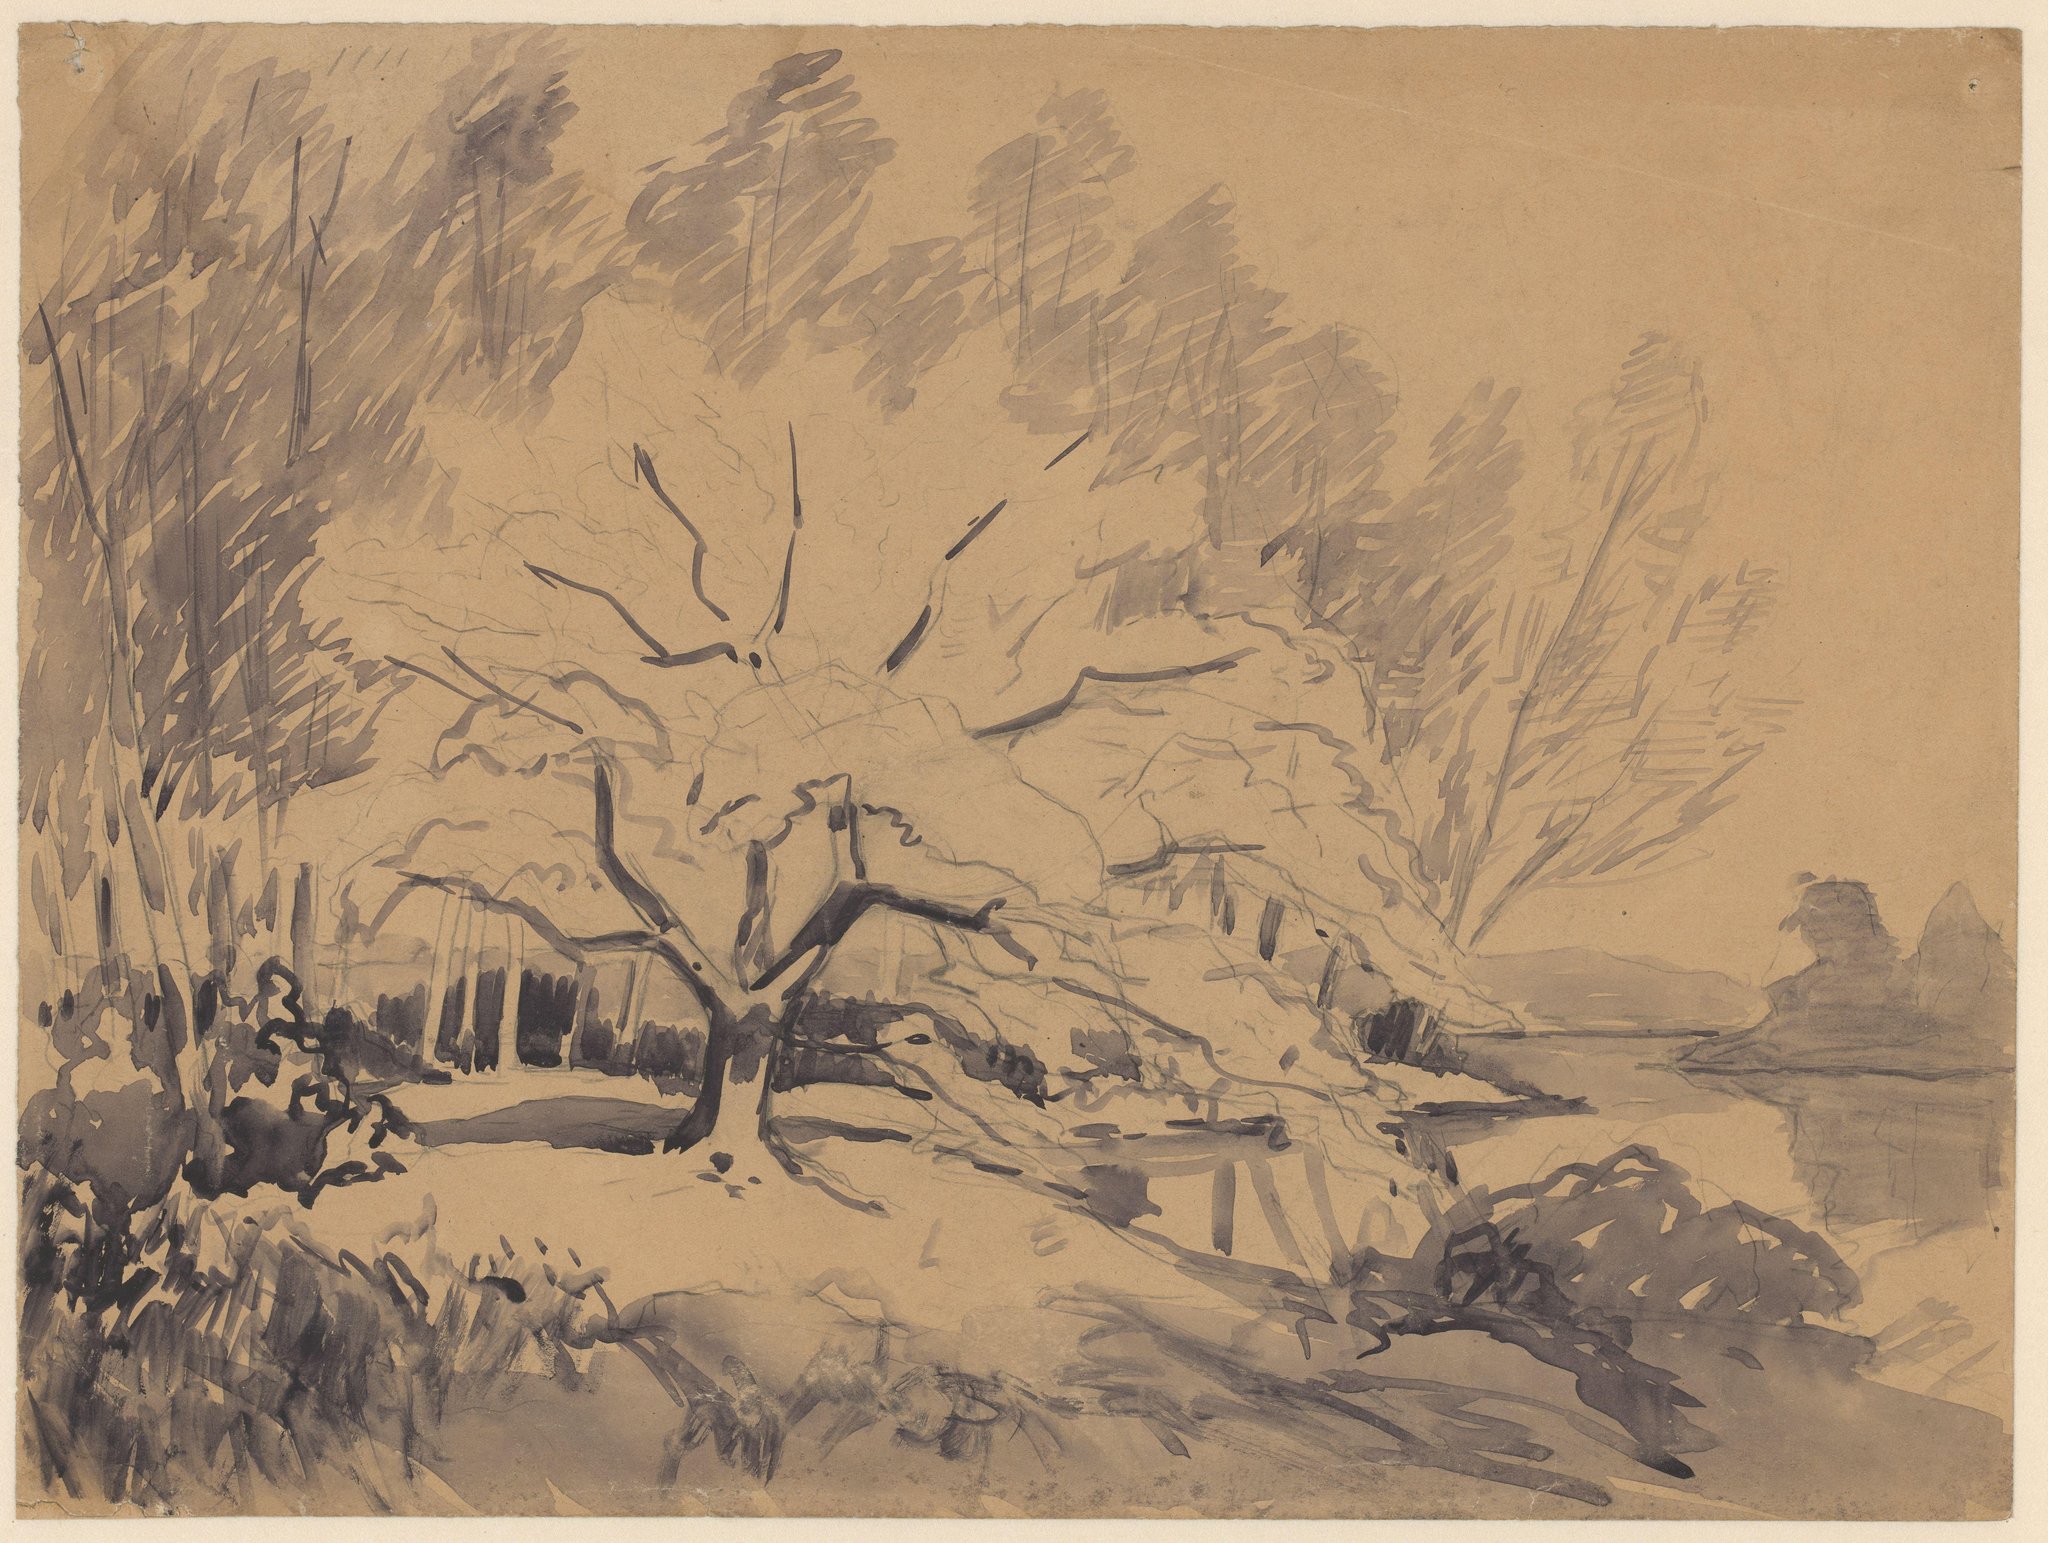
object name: drawing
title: Landschap met brede boom in het midden, rechts een vijver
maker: egbert rubertus derk schaap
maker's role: draughtsman, painter, print maker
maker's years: 1862-1939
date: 1872-1939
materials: chalk, paper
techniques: brush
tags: trees